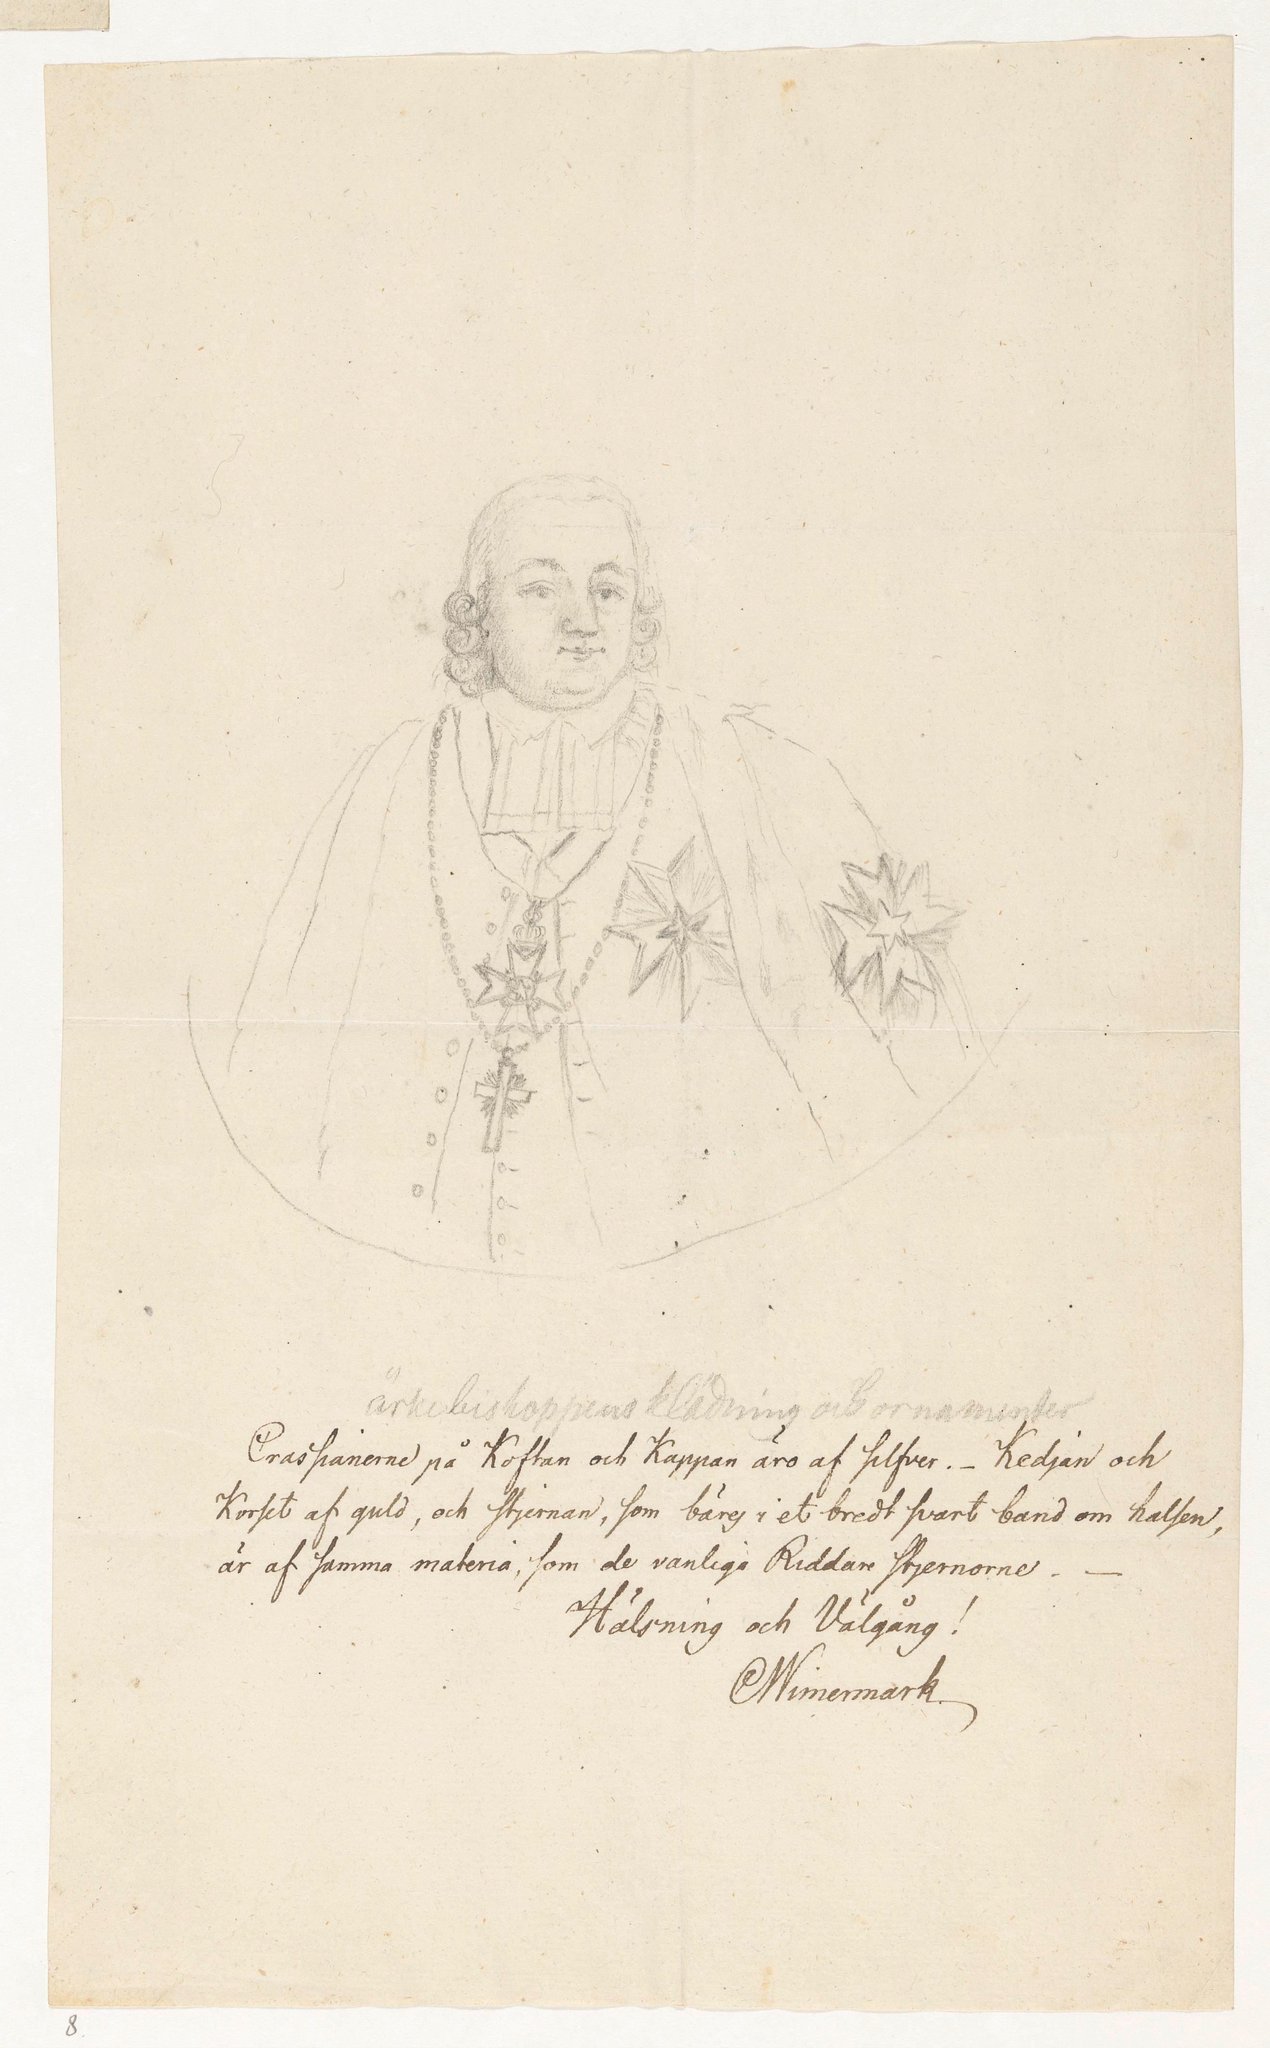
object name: drawing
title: Portret van aartsbisschop Jacob Lindblom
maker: jan brandes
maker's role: draughtsman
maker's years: 1743-1808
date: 1788-1808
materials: paper, pencil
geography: skälsebo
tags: archbishop, bishop, etc. (roman catholic), historical persons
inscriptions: inscription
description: Portret van aartsbisschop Jacob Lindblom. In kleding versierd met sterren en kruizen. Met opschrift.